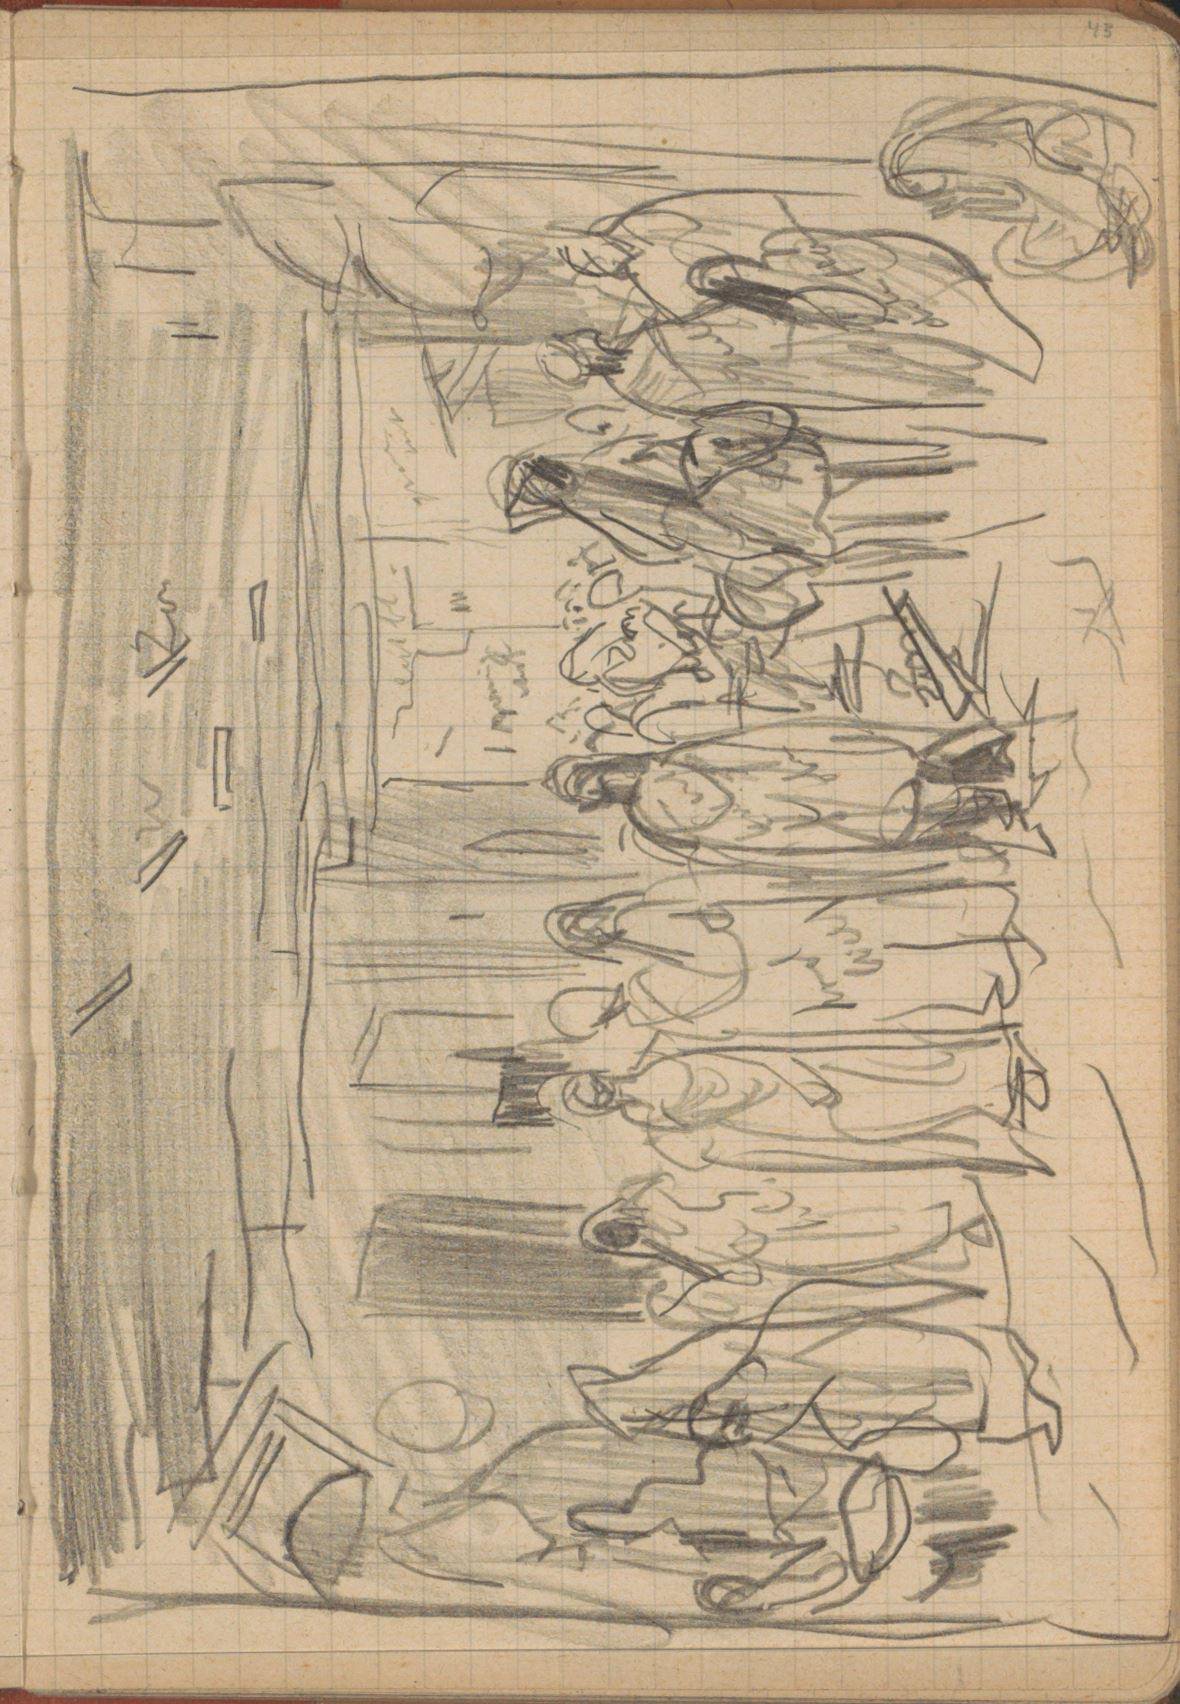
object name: sketchbook leaf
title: Figuren in een overdekte straat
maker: marius bauer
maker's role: draughtsman, print maker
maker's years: 1867-1932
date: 1909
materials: pencil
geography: tunis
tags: street (+ city(-scape) with figures, staffage)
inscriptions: kleurnotitie, handgeschreven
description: Pagina 43 uit een schetsboek met 67 bladen.